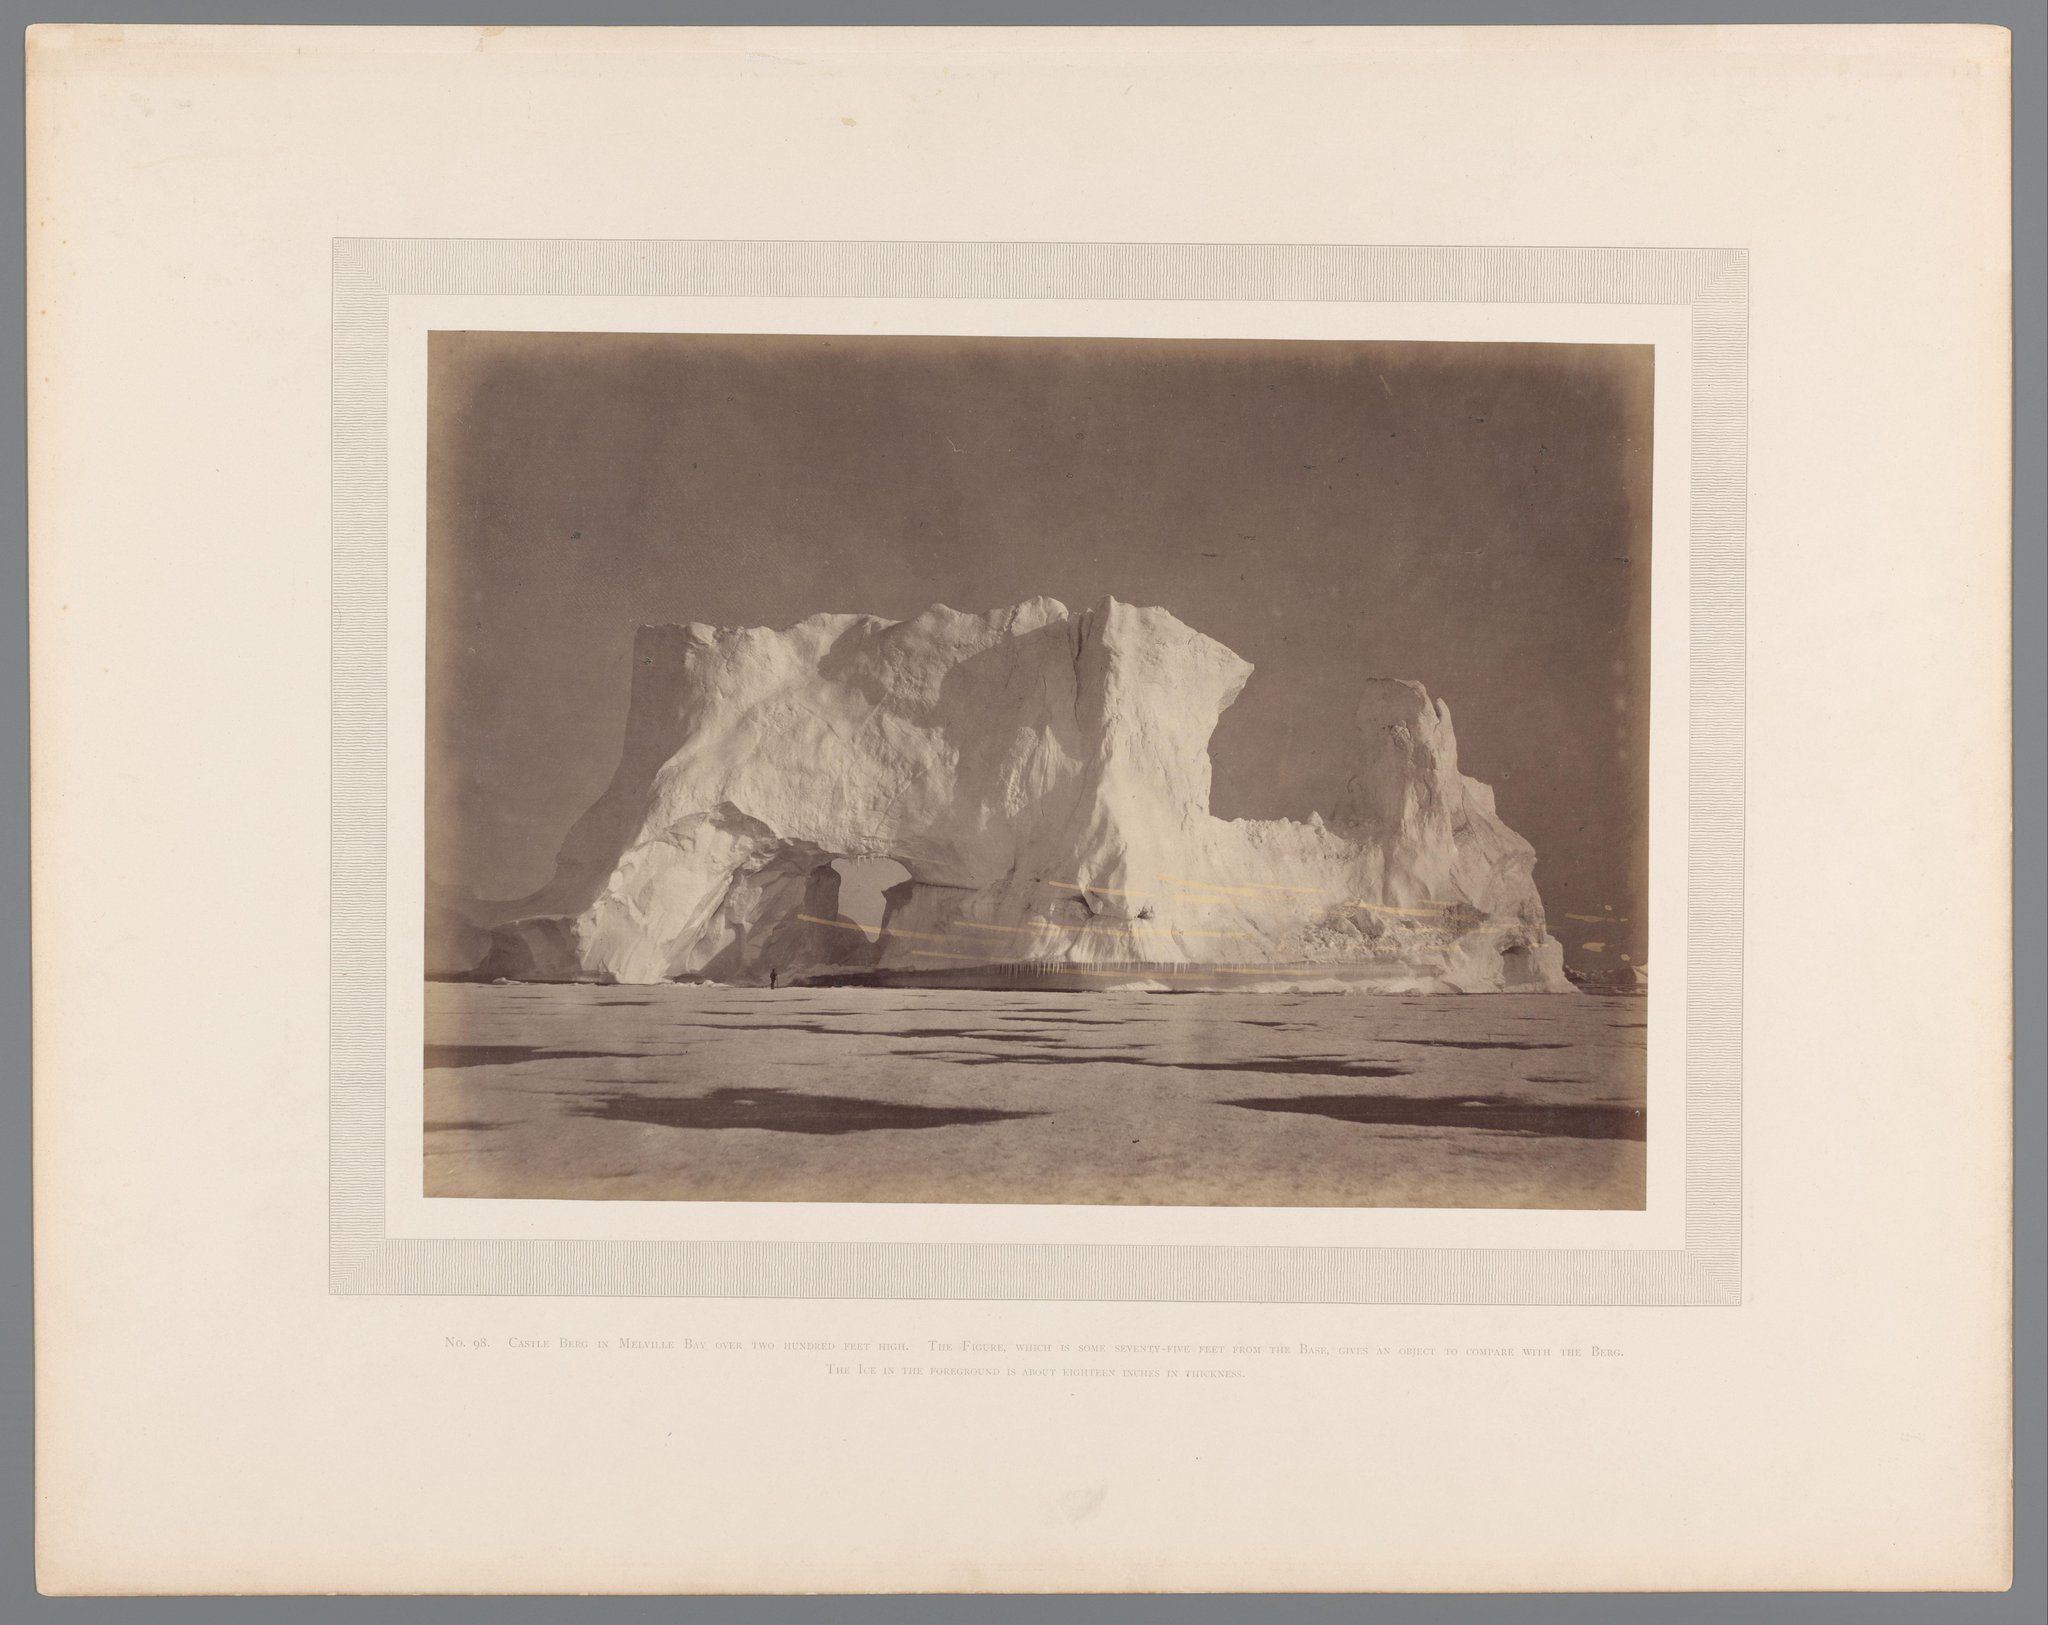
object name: photograph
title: Castle Berg in Melville Bay, Groenland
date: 1869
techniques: albumen print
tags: greenland